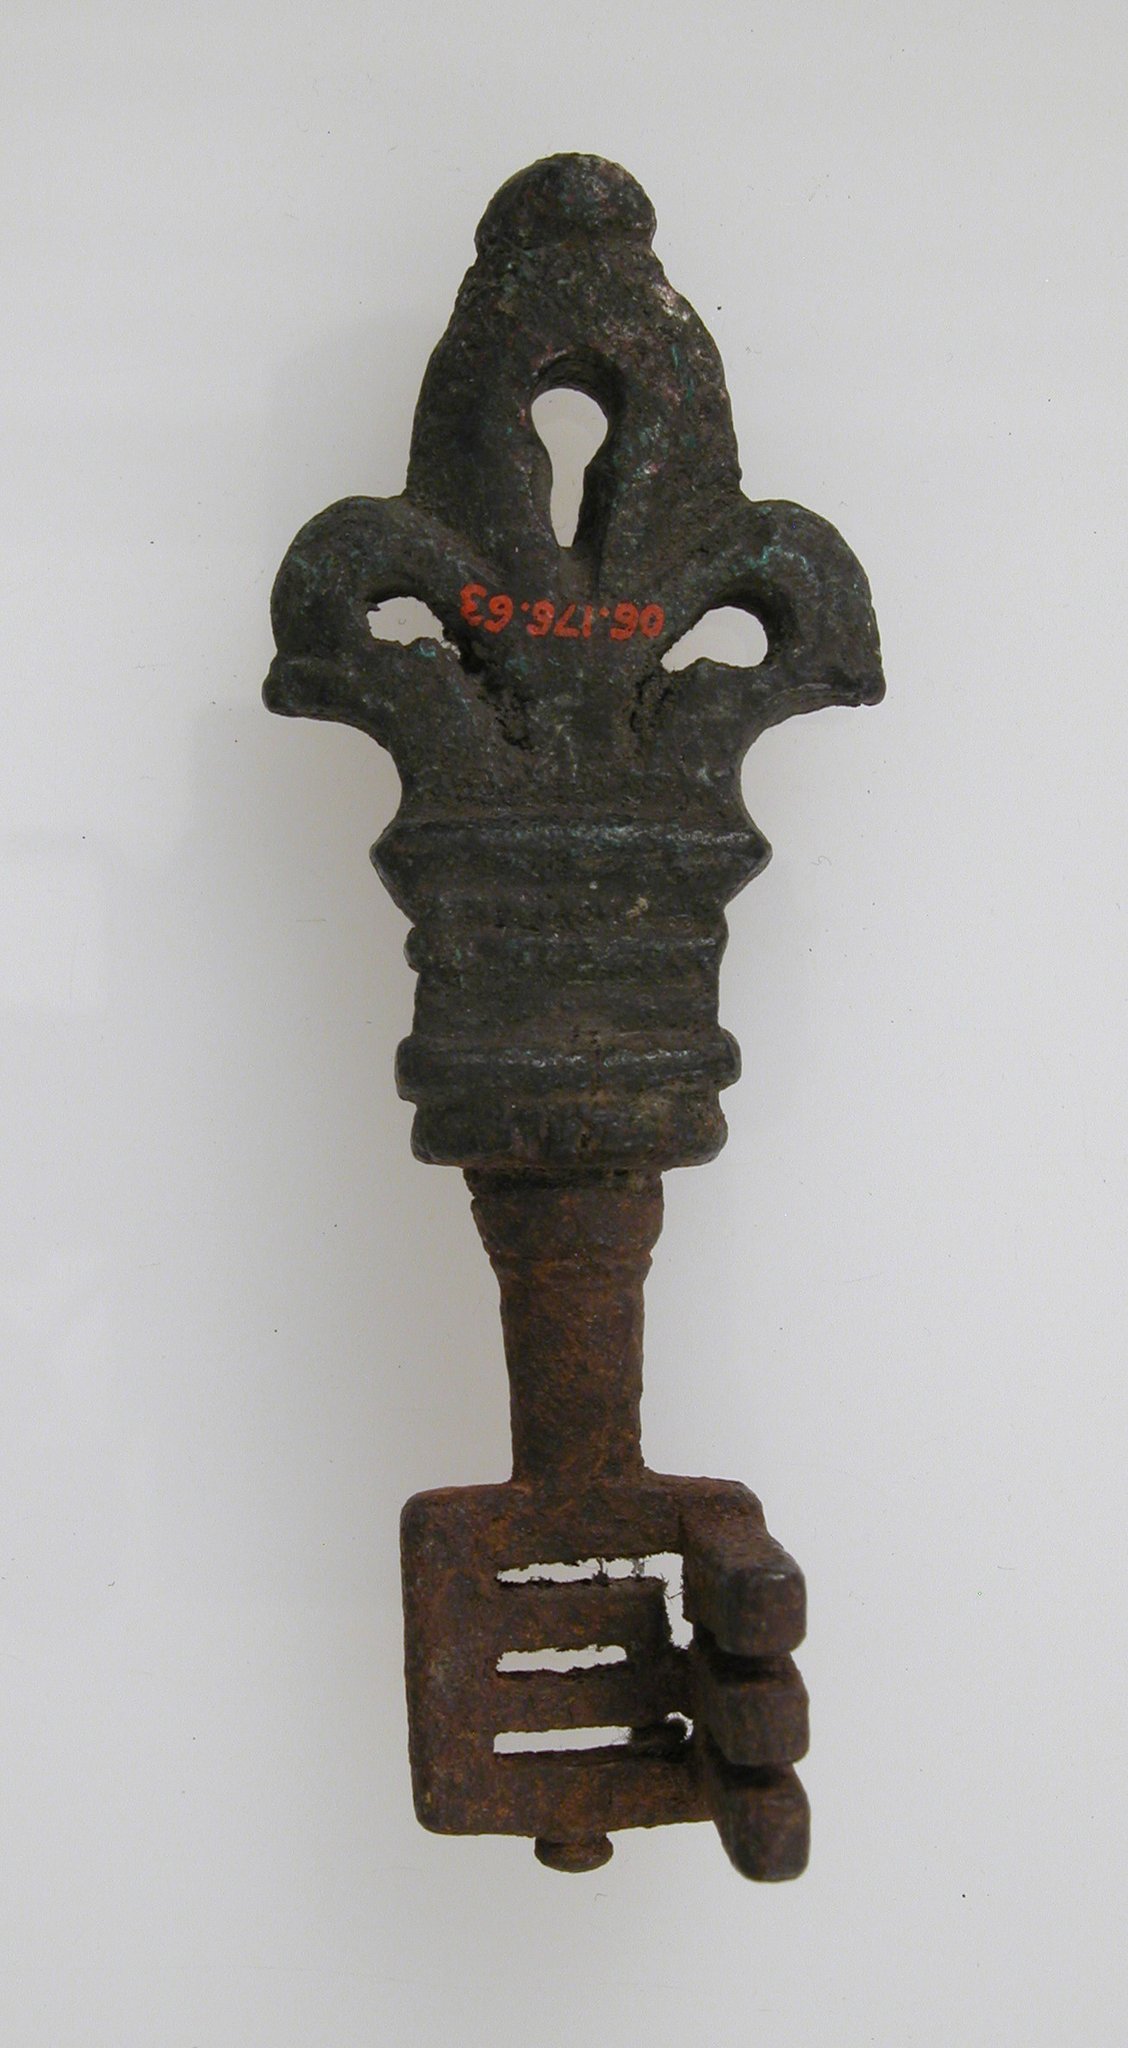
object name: key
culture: roman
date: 1-700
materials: copper alloy, iron